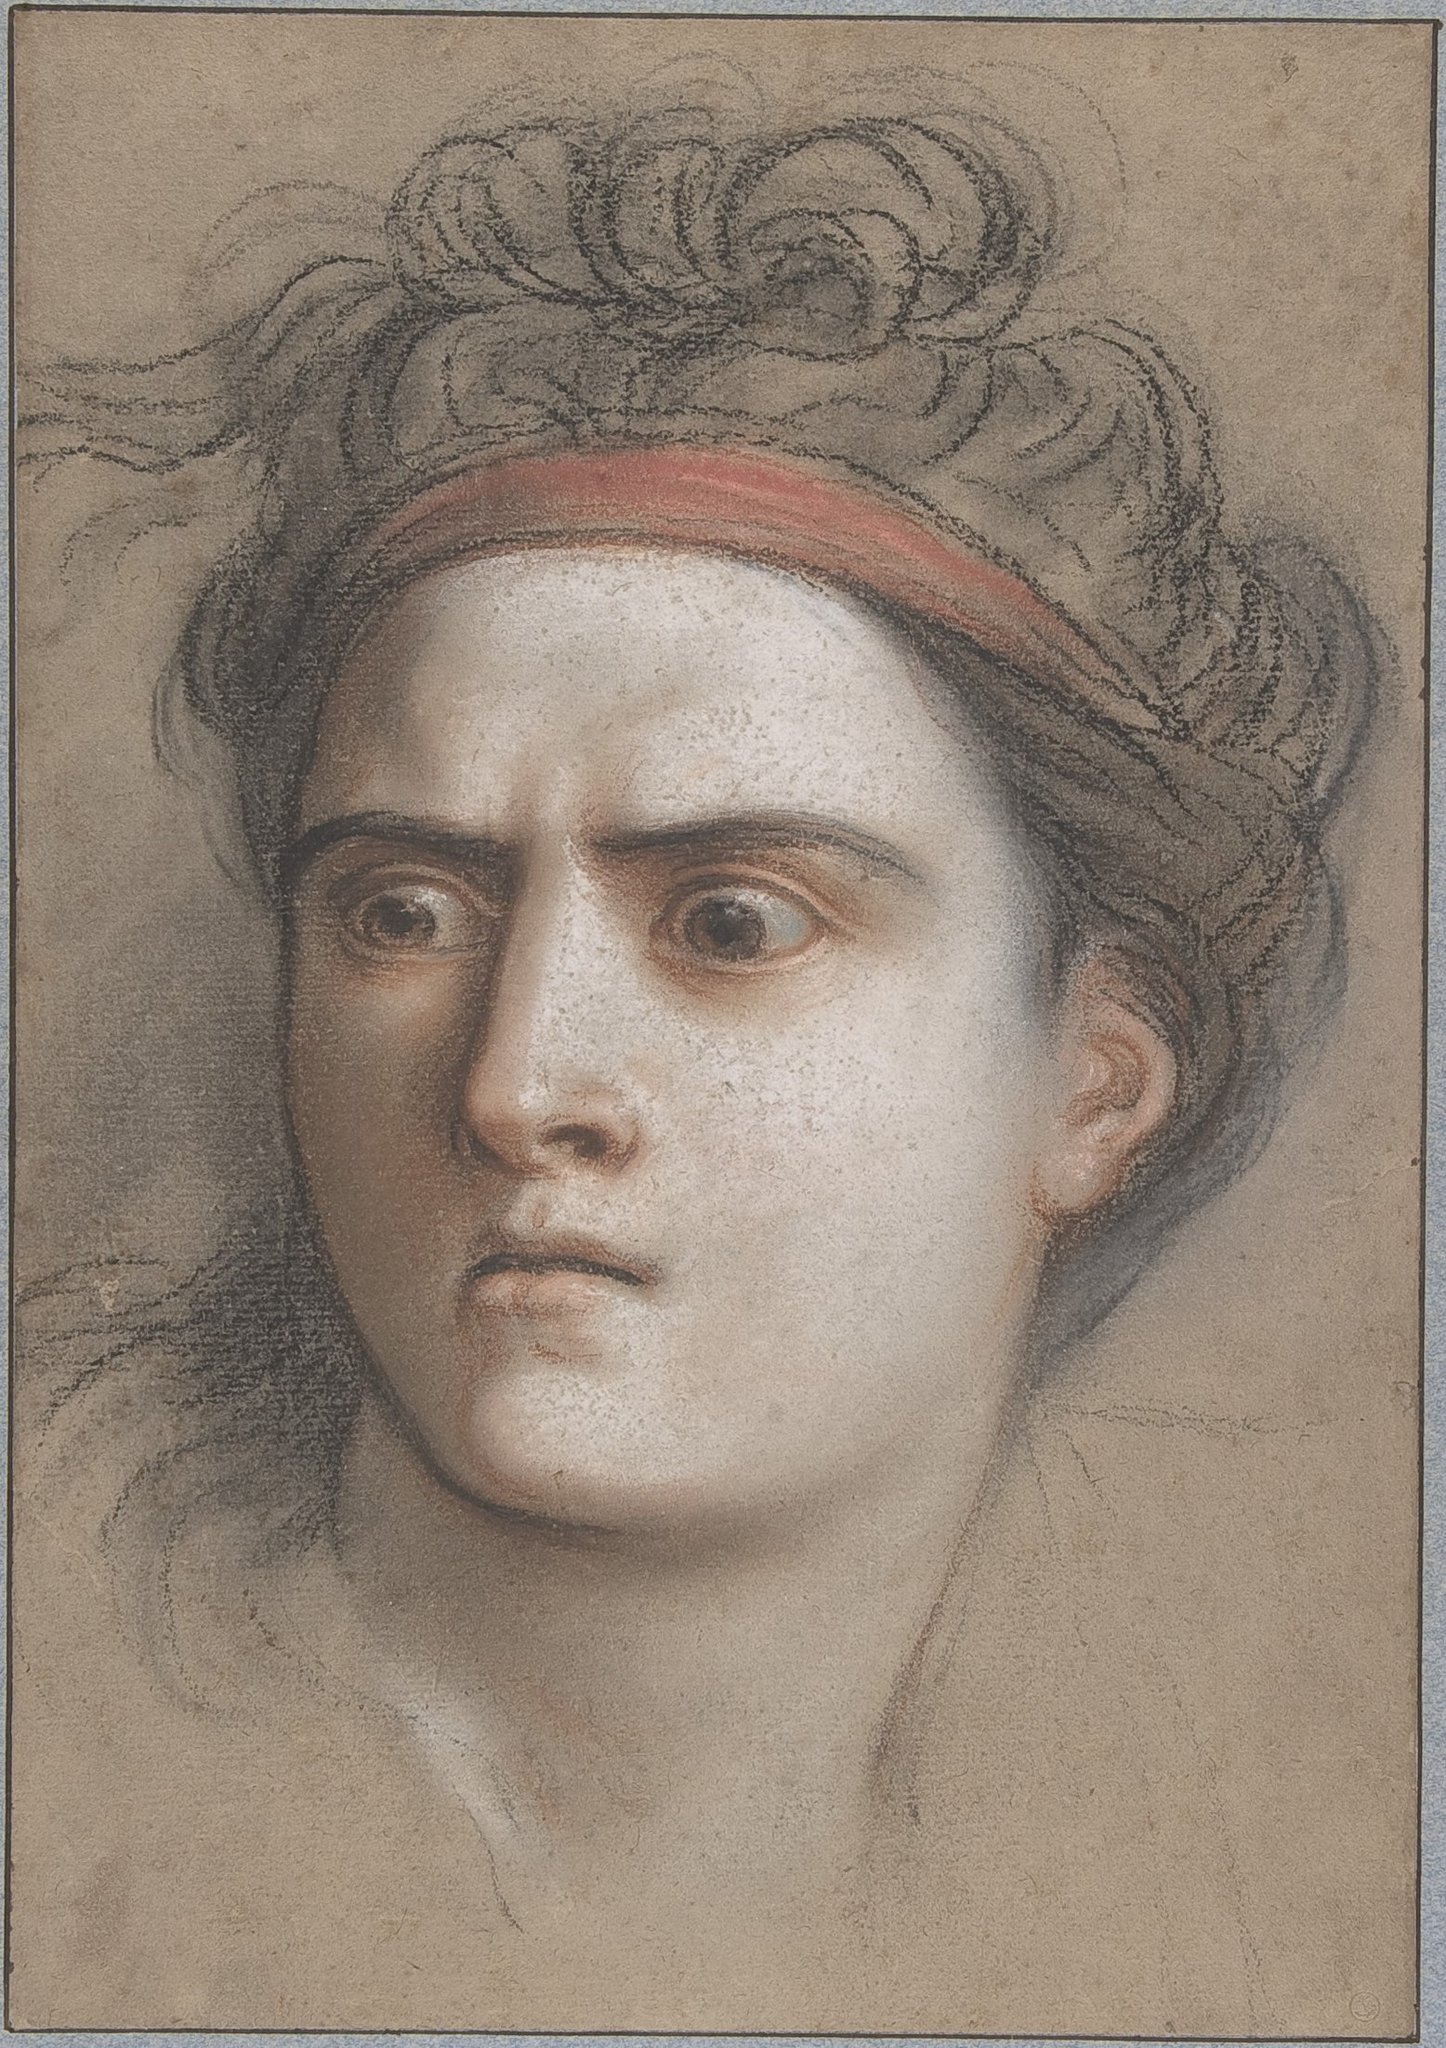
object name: drawing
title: Medea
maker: charles antoine coypel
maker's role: artist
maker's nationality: french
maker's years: 1694-1752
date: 1715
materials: ink, paper, pastel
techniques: pen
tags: anger,women,medea